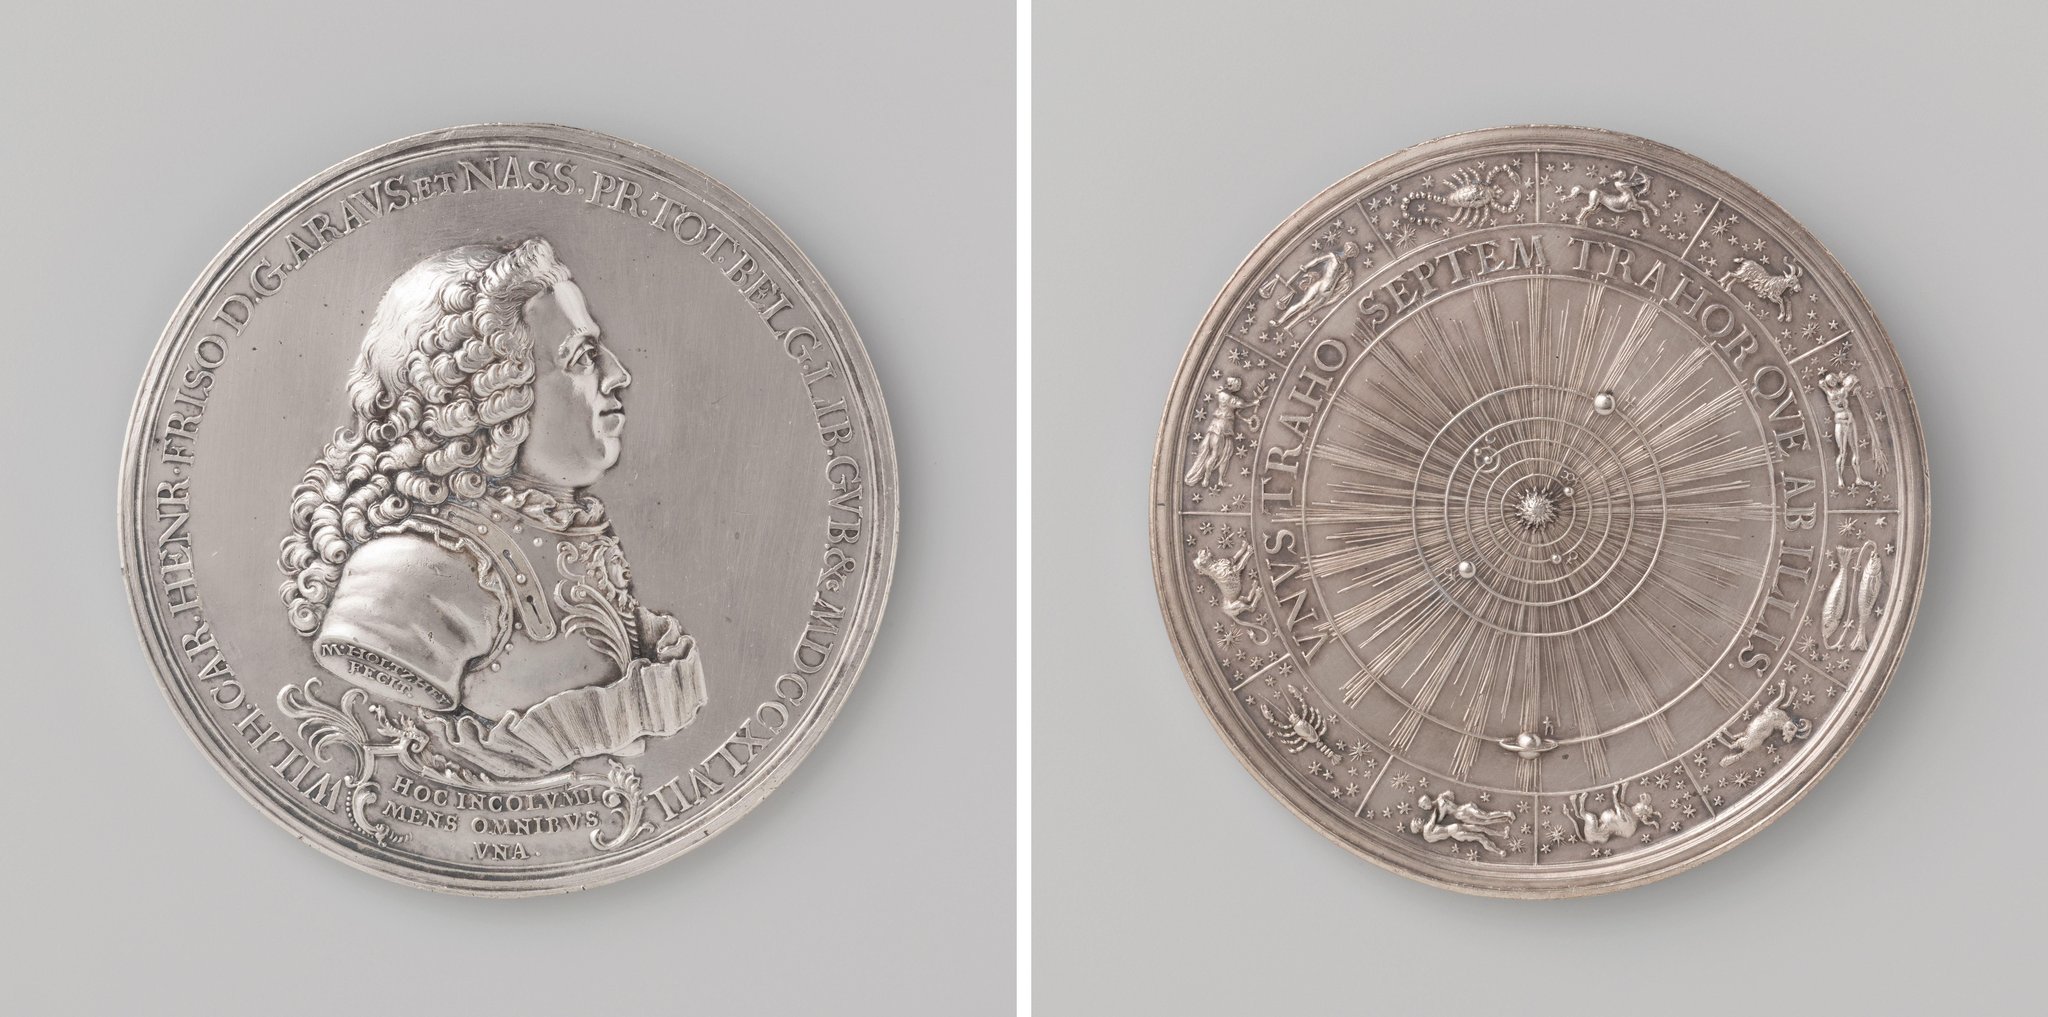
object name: history medal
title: Verheffing van de prins van Oranje tot stadhouder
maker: martinus holtzhey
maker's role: medailleur, muntmaker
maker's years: 1697-1764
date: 1747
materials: silver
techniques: striking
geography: amsterdam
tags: willem iv (prins van oranje-nassau)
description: Zilveren penning. Voorzijde: borststuk man boven opschrift in sierlijst binnen omschrift. Keerzijde: planeten die baan rond zon beschrijven binnen omschrift en tekens van dierenriem